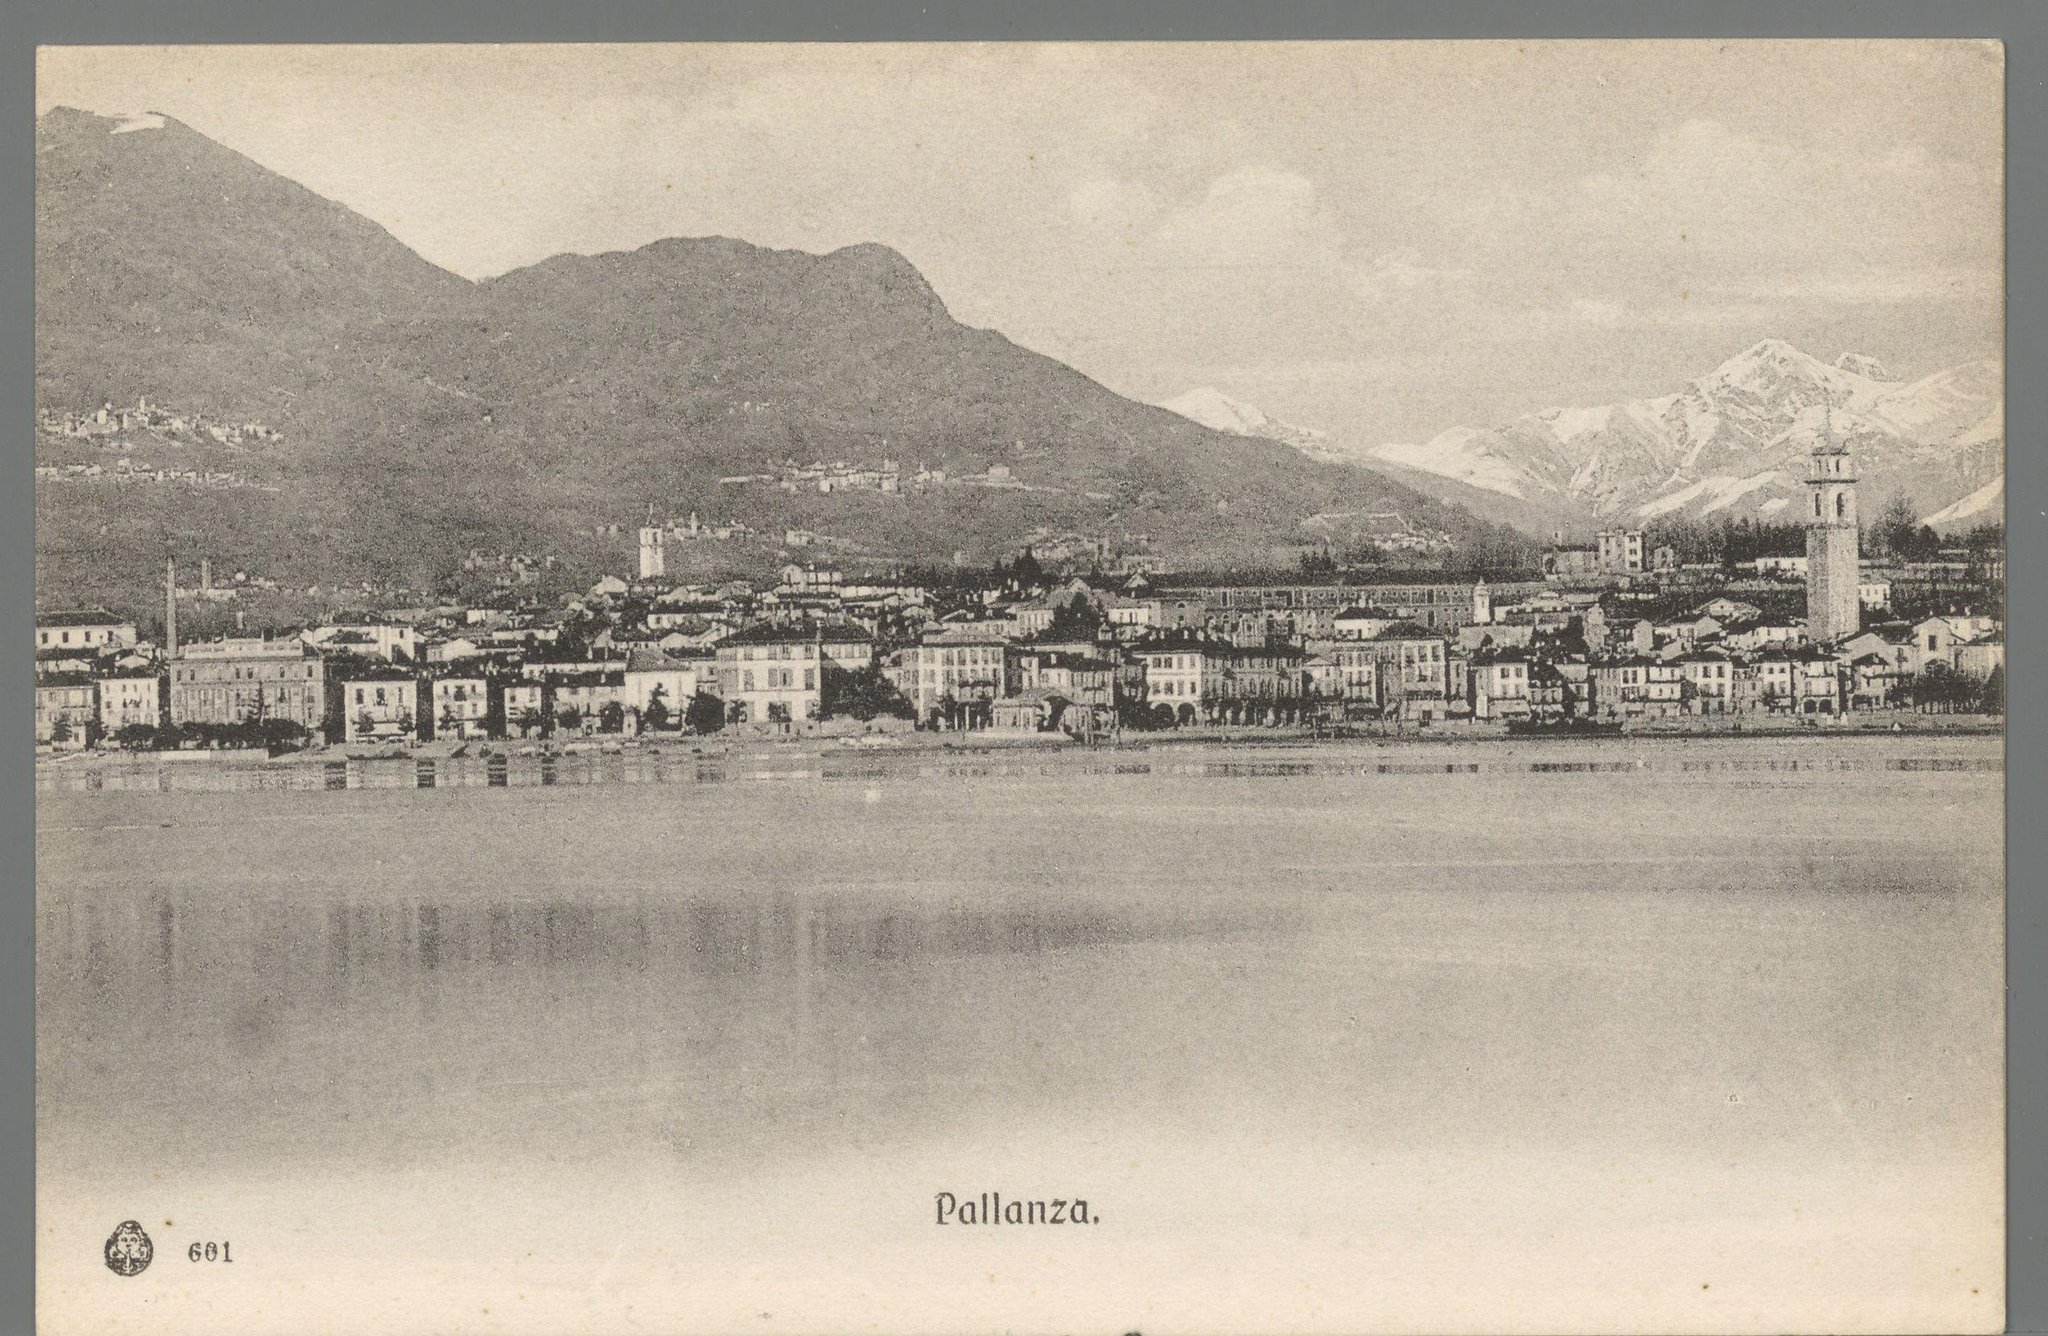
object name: photomechanical print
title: Pallanza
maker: Anonymous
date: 1906-1909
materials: cardboard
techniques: photograph, writing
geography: zurich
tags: lake, city-view, and landscape with man-made constructions (+ city(-scape) with figures, staffage)